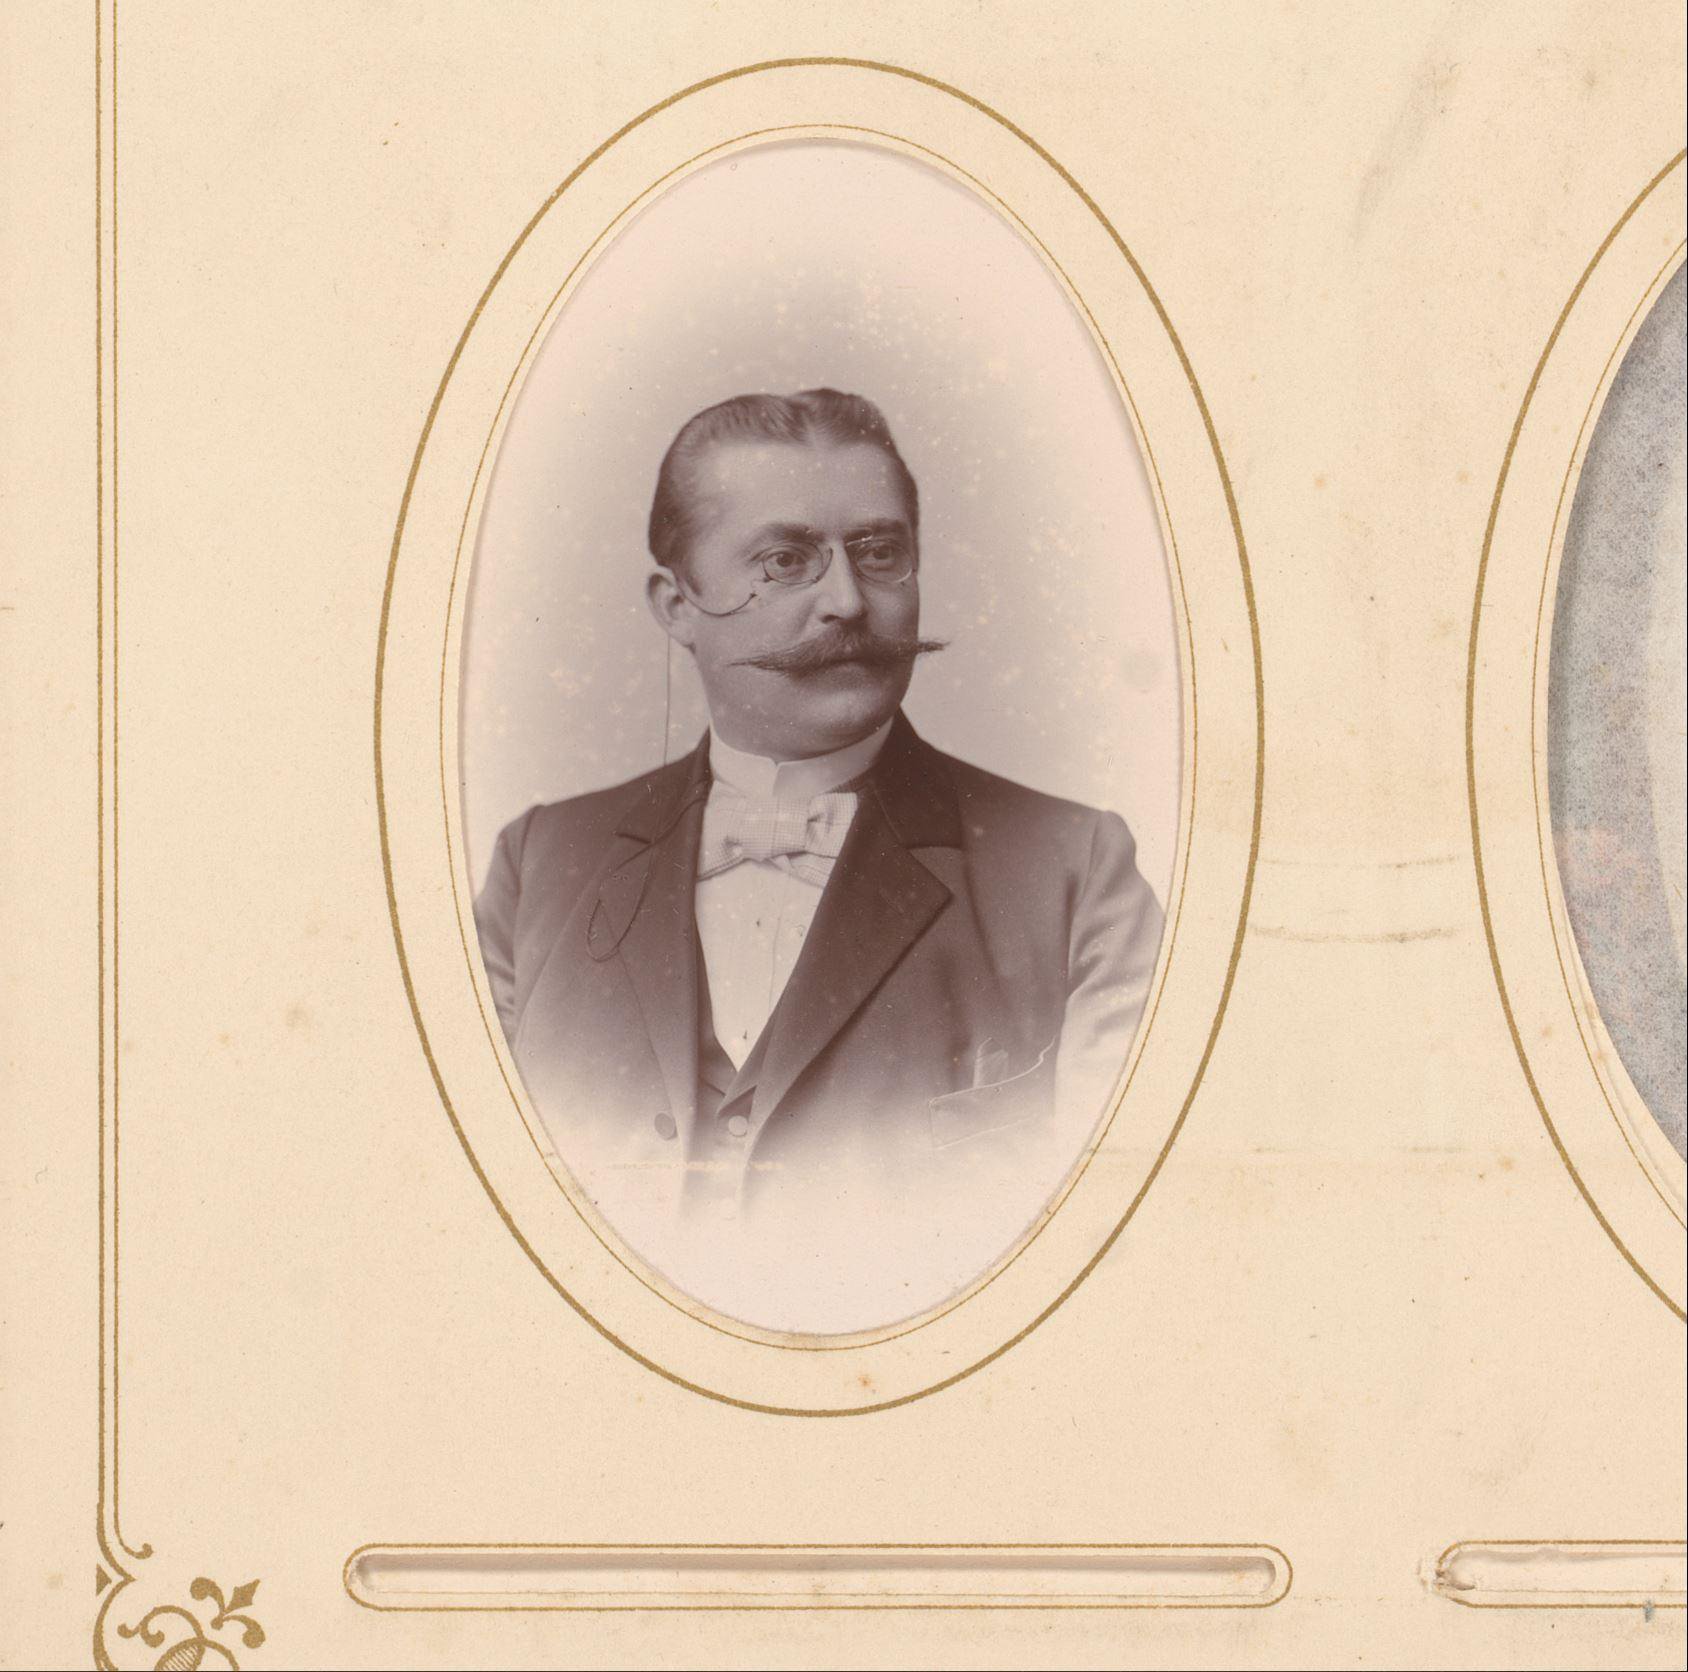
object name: photograph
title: Portret van een man met snor, aangeduid als Gustav Peter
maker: ernst von heyman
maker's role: fotograaf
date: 1880-1940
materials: cardboard, photographic support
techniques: collodion silver print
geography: bremen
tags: moustache, historical persons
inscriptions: name: ‘Gustav Peter’, inscription: ‘Ernst von Heyman/ Hof-Photograph/ Bremen/ Domshof 27, Rutenhof II. Stock./ Die Originalplatte bleibt zum Nachbestellen aufbewahrt.’